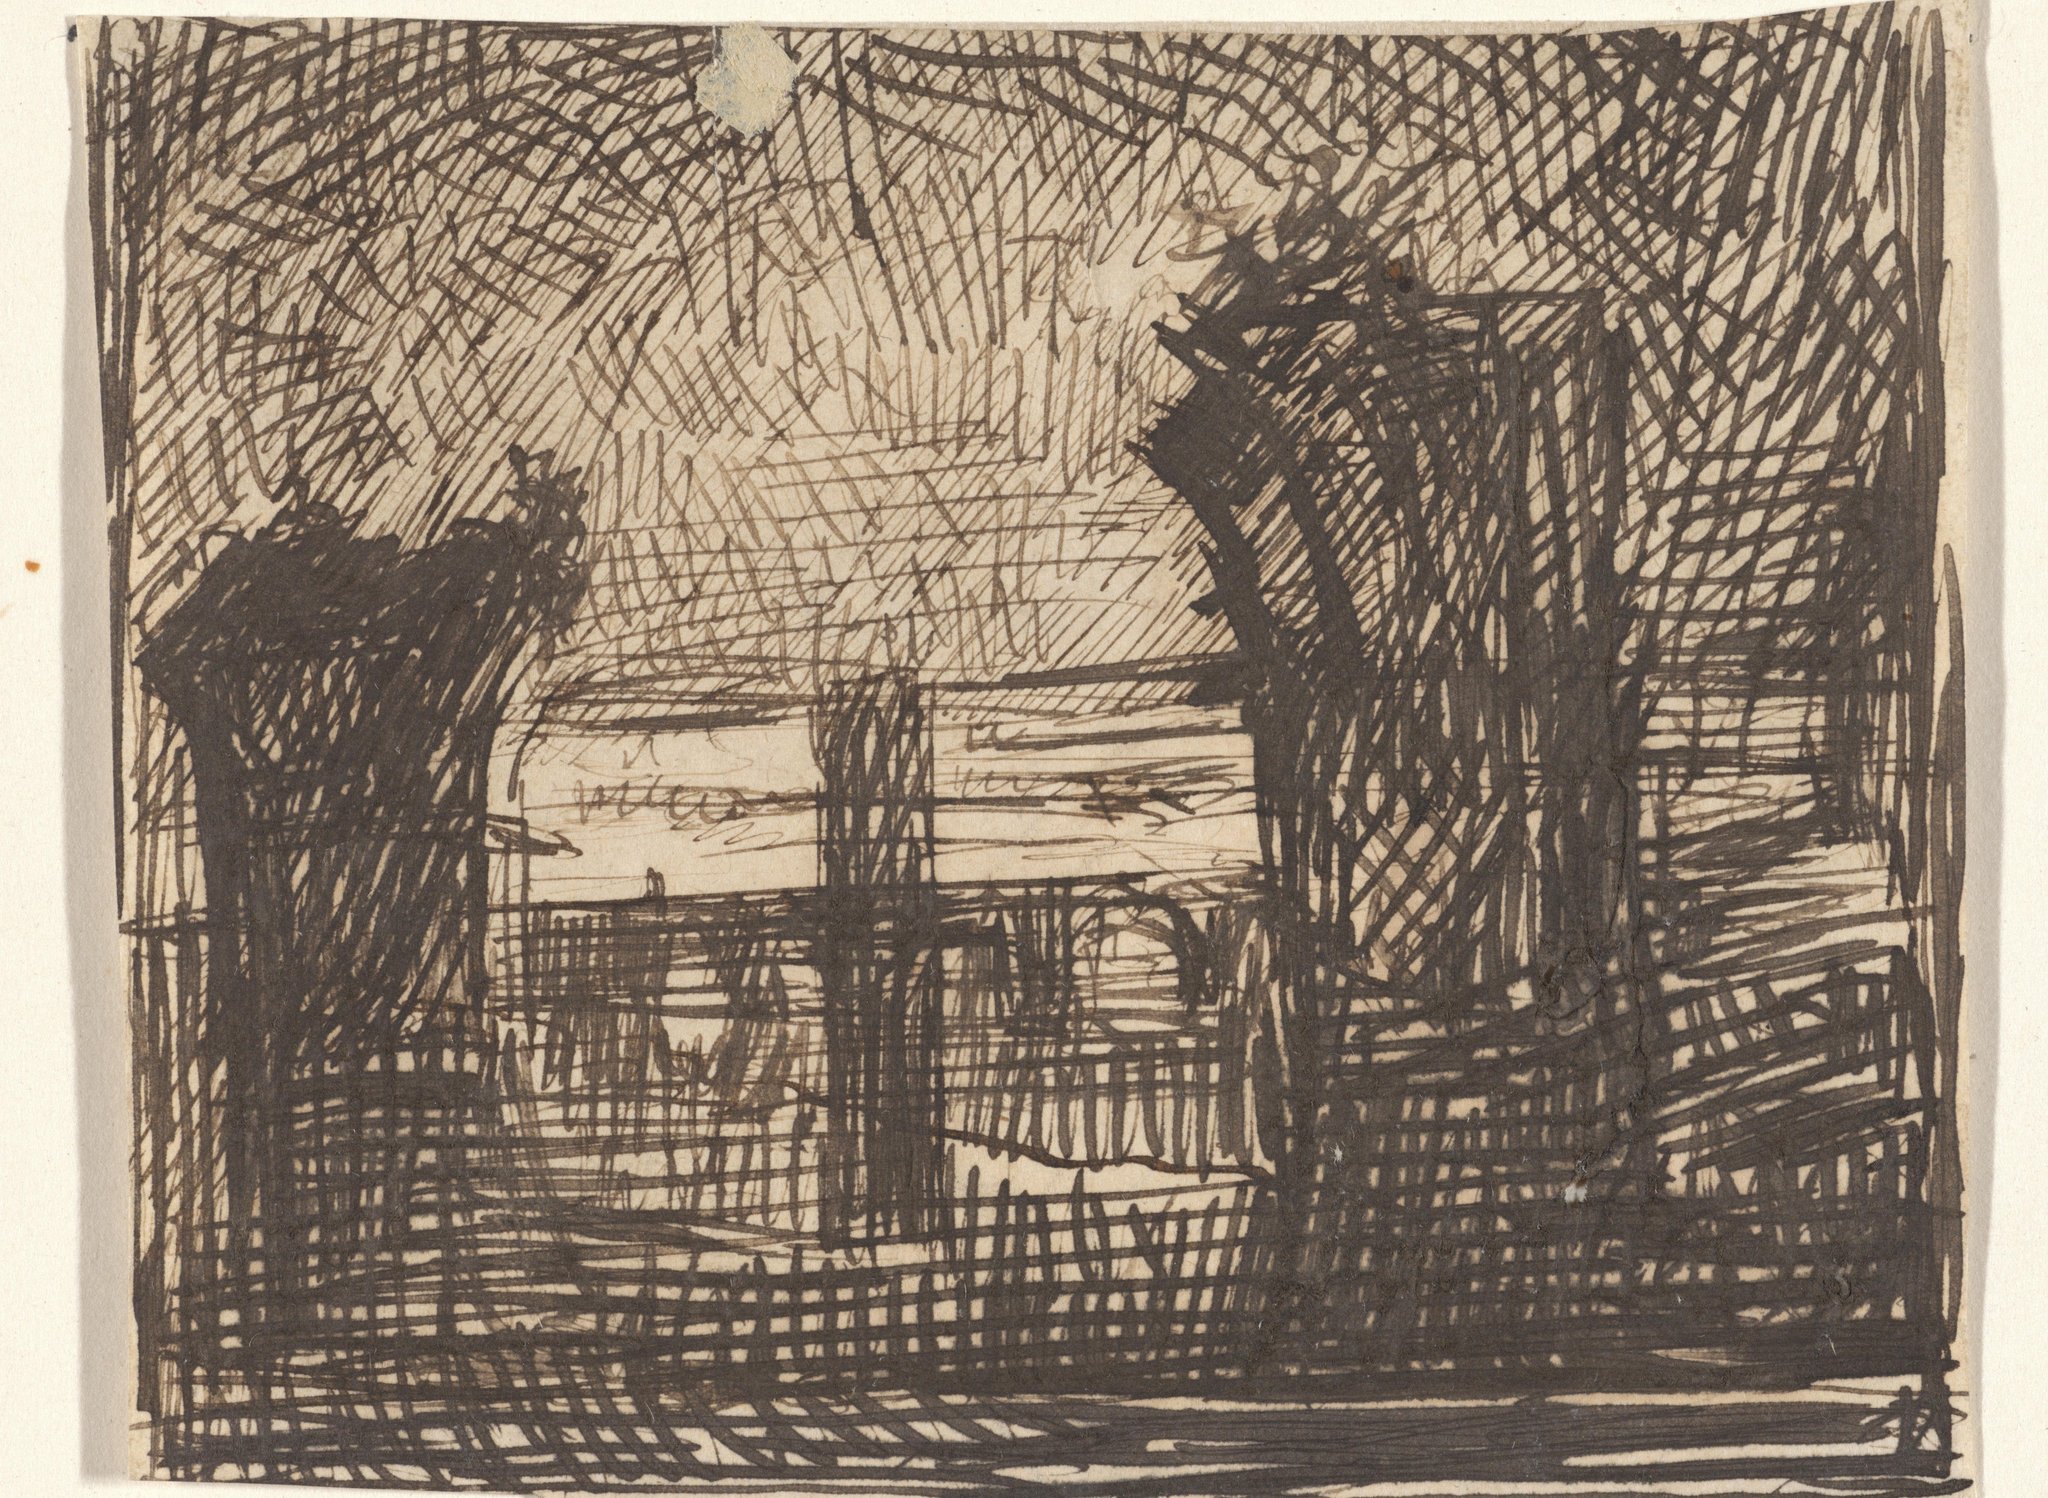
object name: drawing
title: Gezicht op ruïnes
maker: thomas cool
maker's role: draughtsman, painter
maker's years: 1851-1904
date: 1861-1904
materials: ink, paper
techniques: pen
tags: ruin of a building ~ architecture, italy